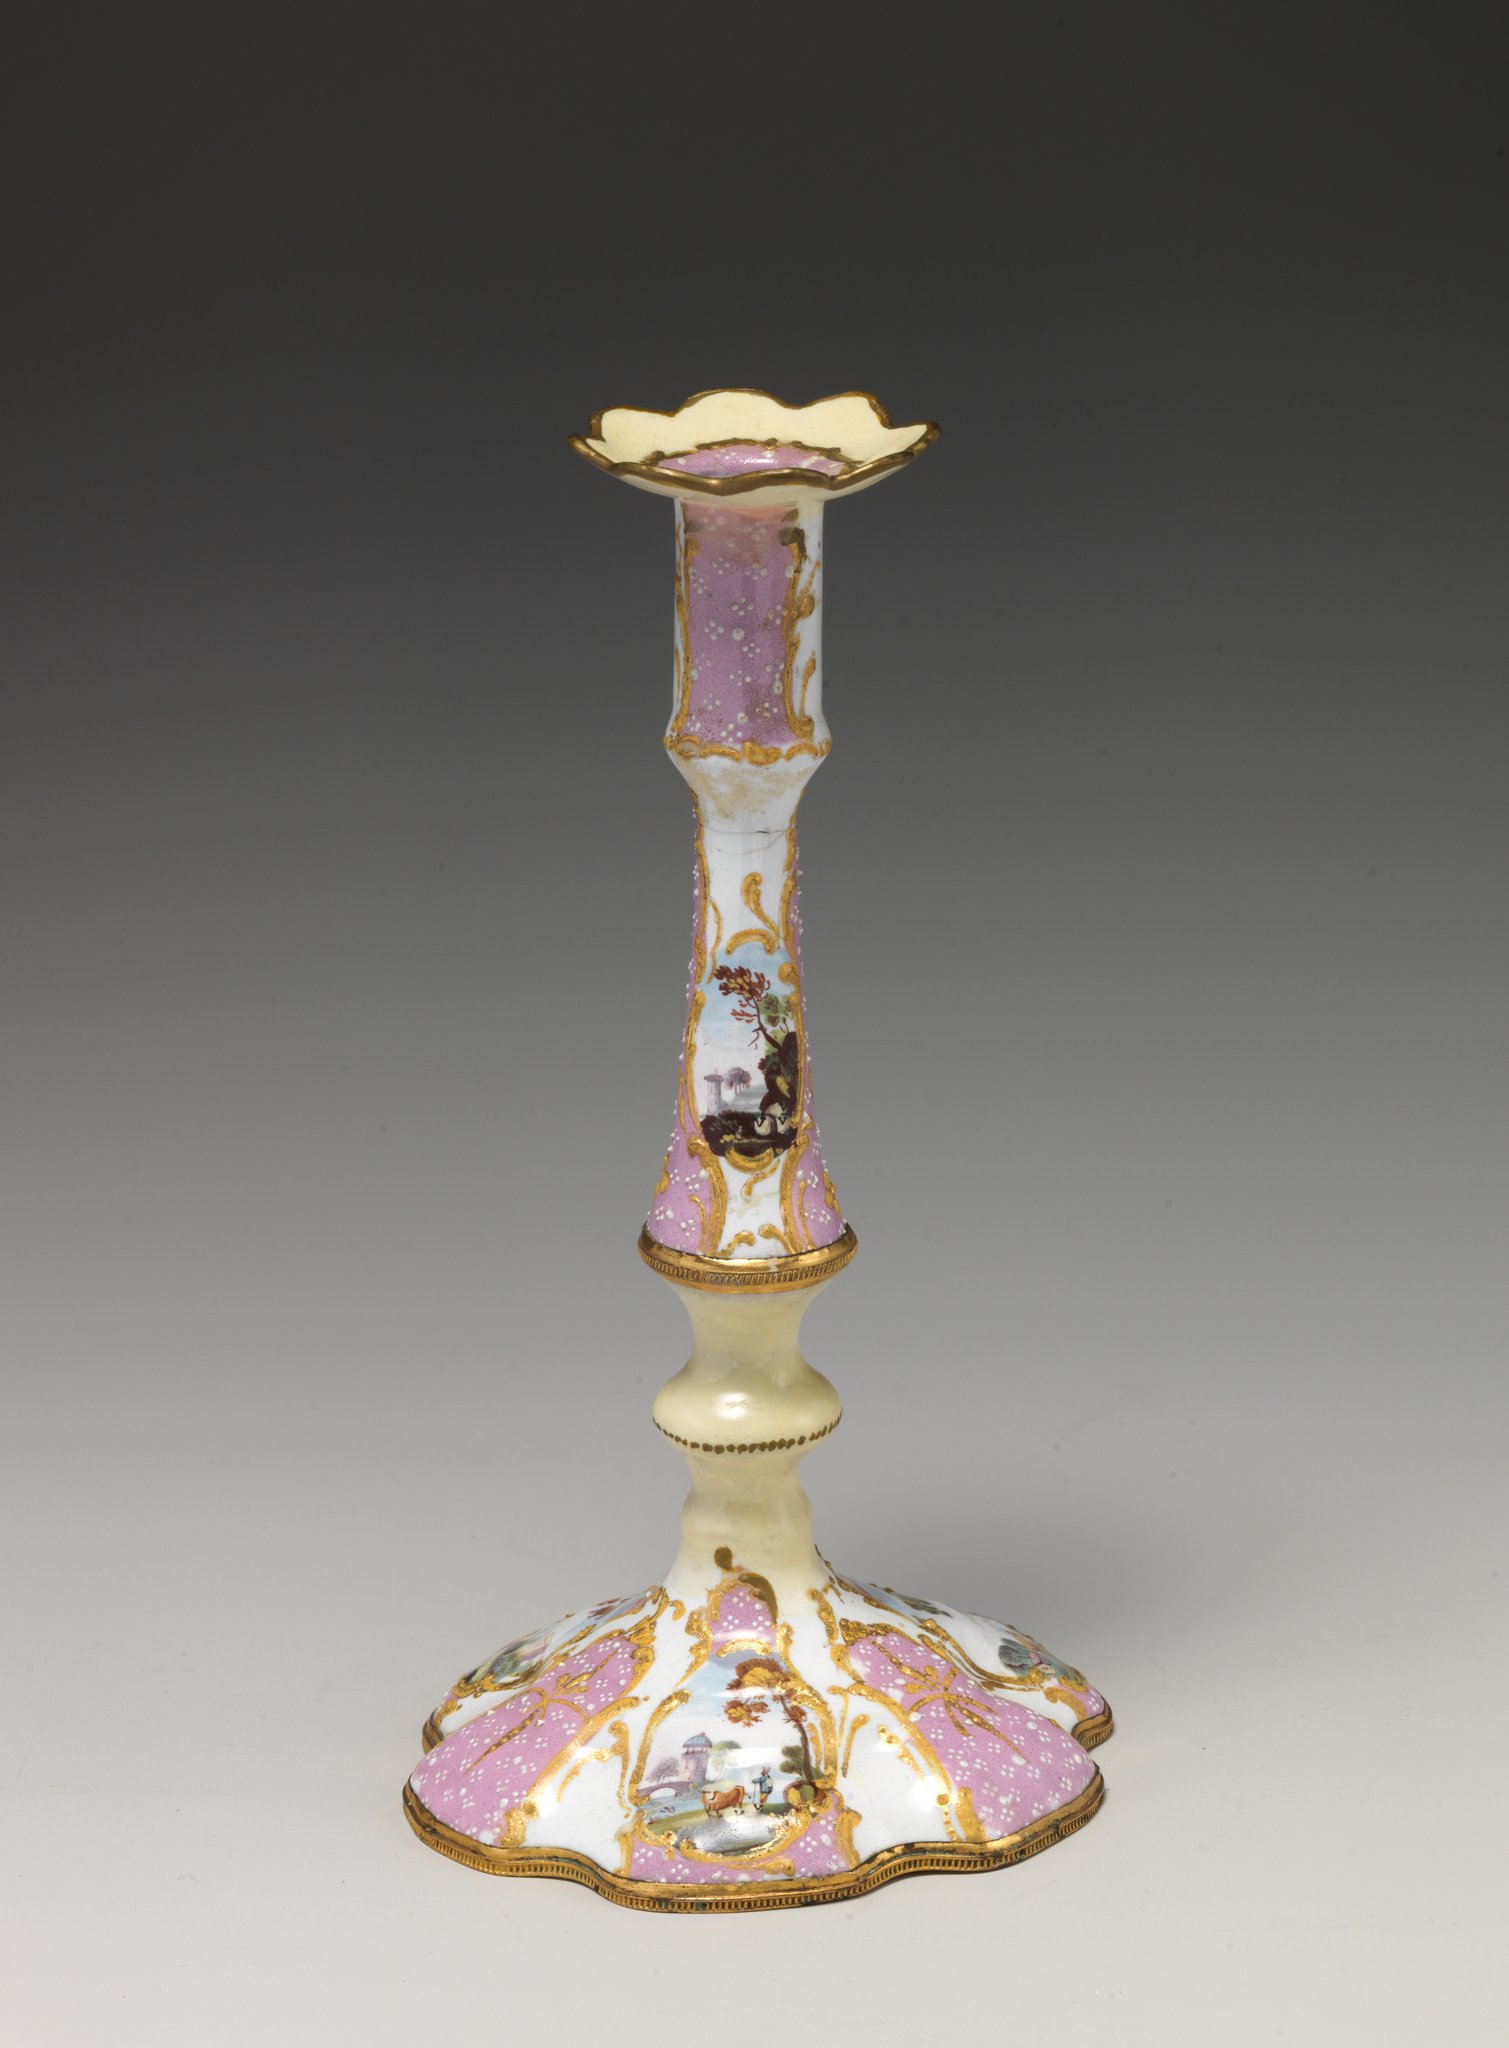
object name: taperstick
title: Taperstick (one of a pair)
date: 1765-1775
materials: copper, enamel